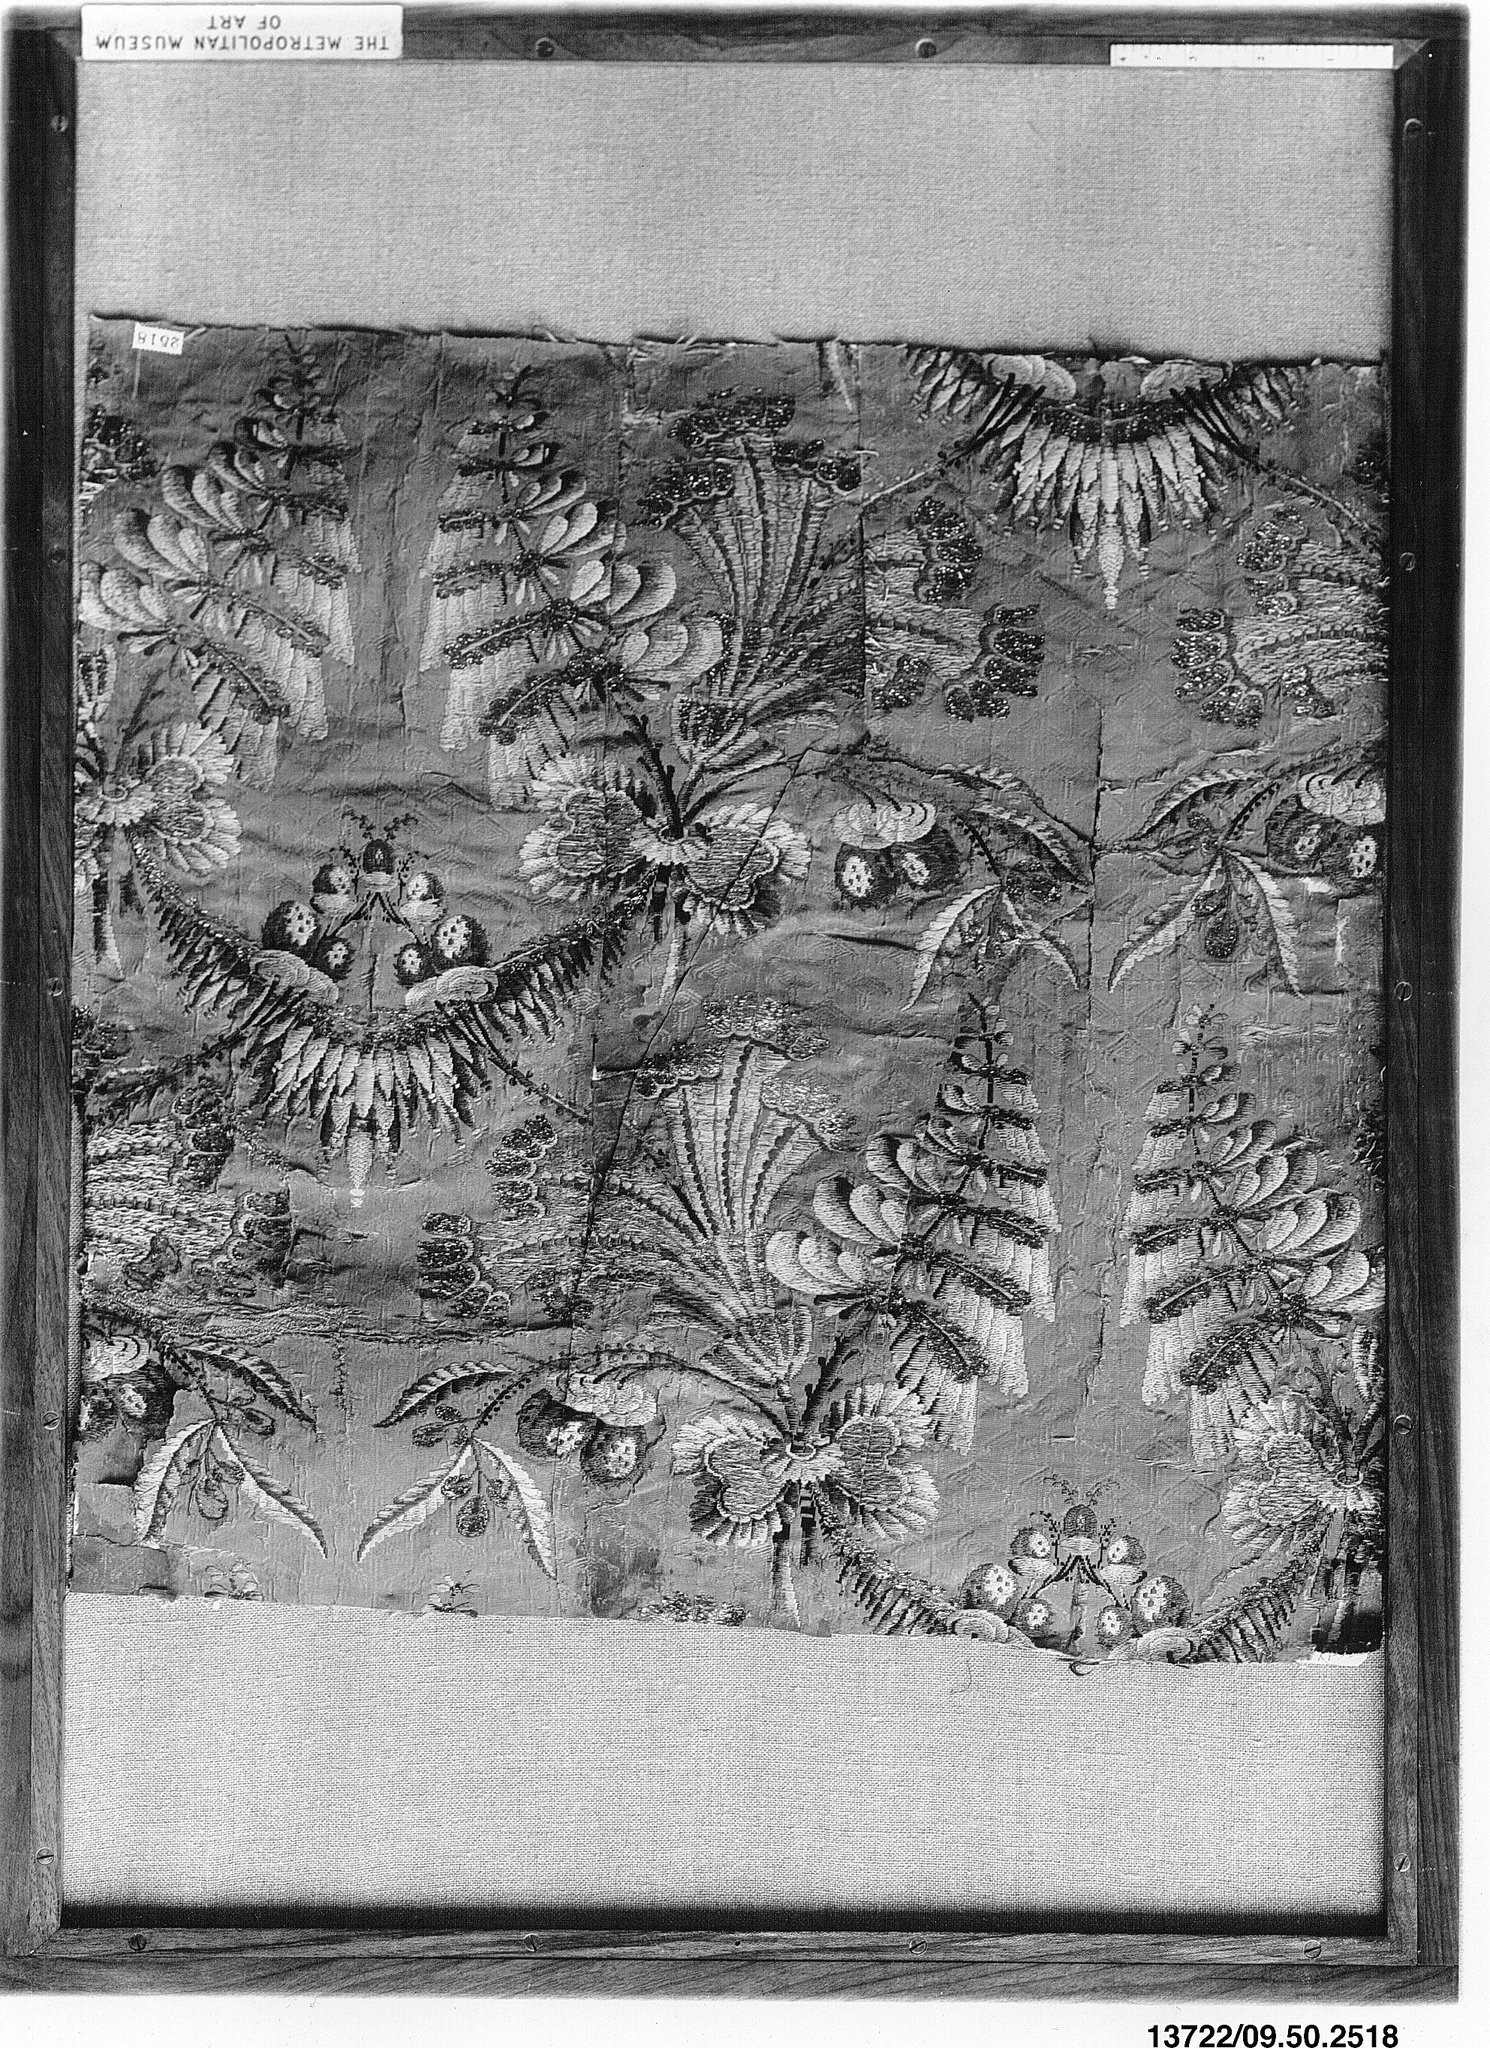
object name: piece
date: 1760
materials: metal thread, silk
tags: flowers,leaves